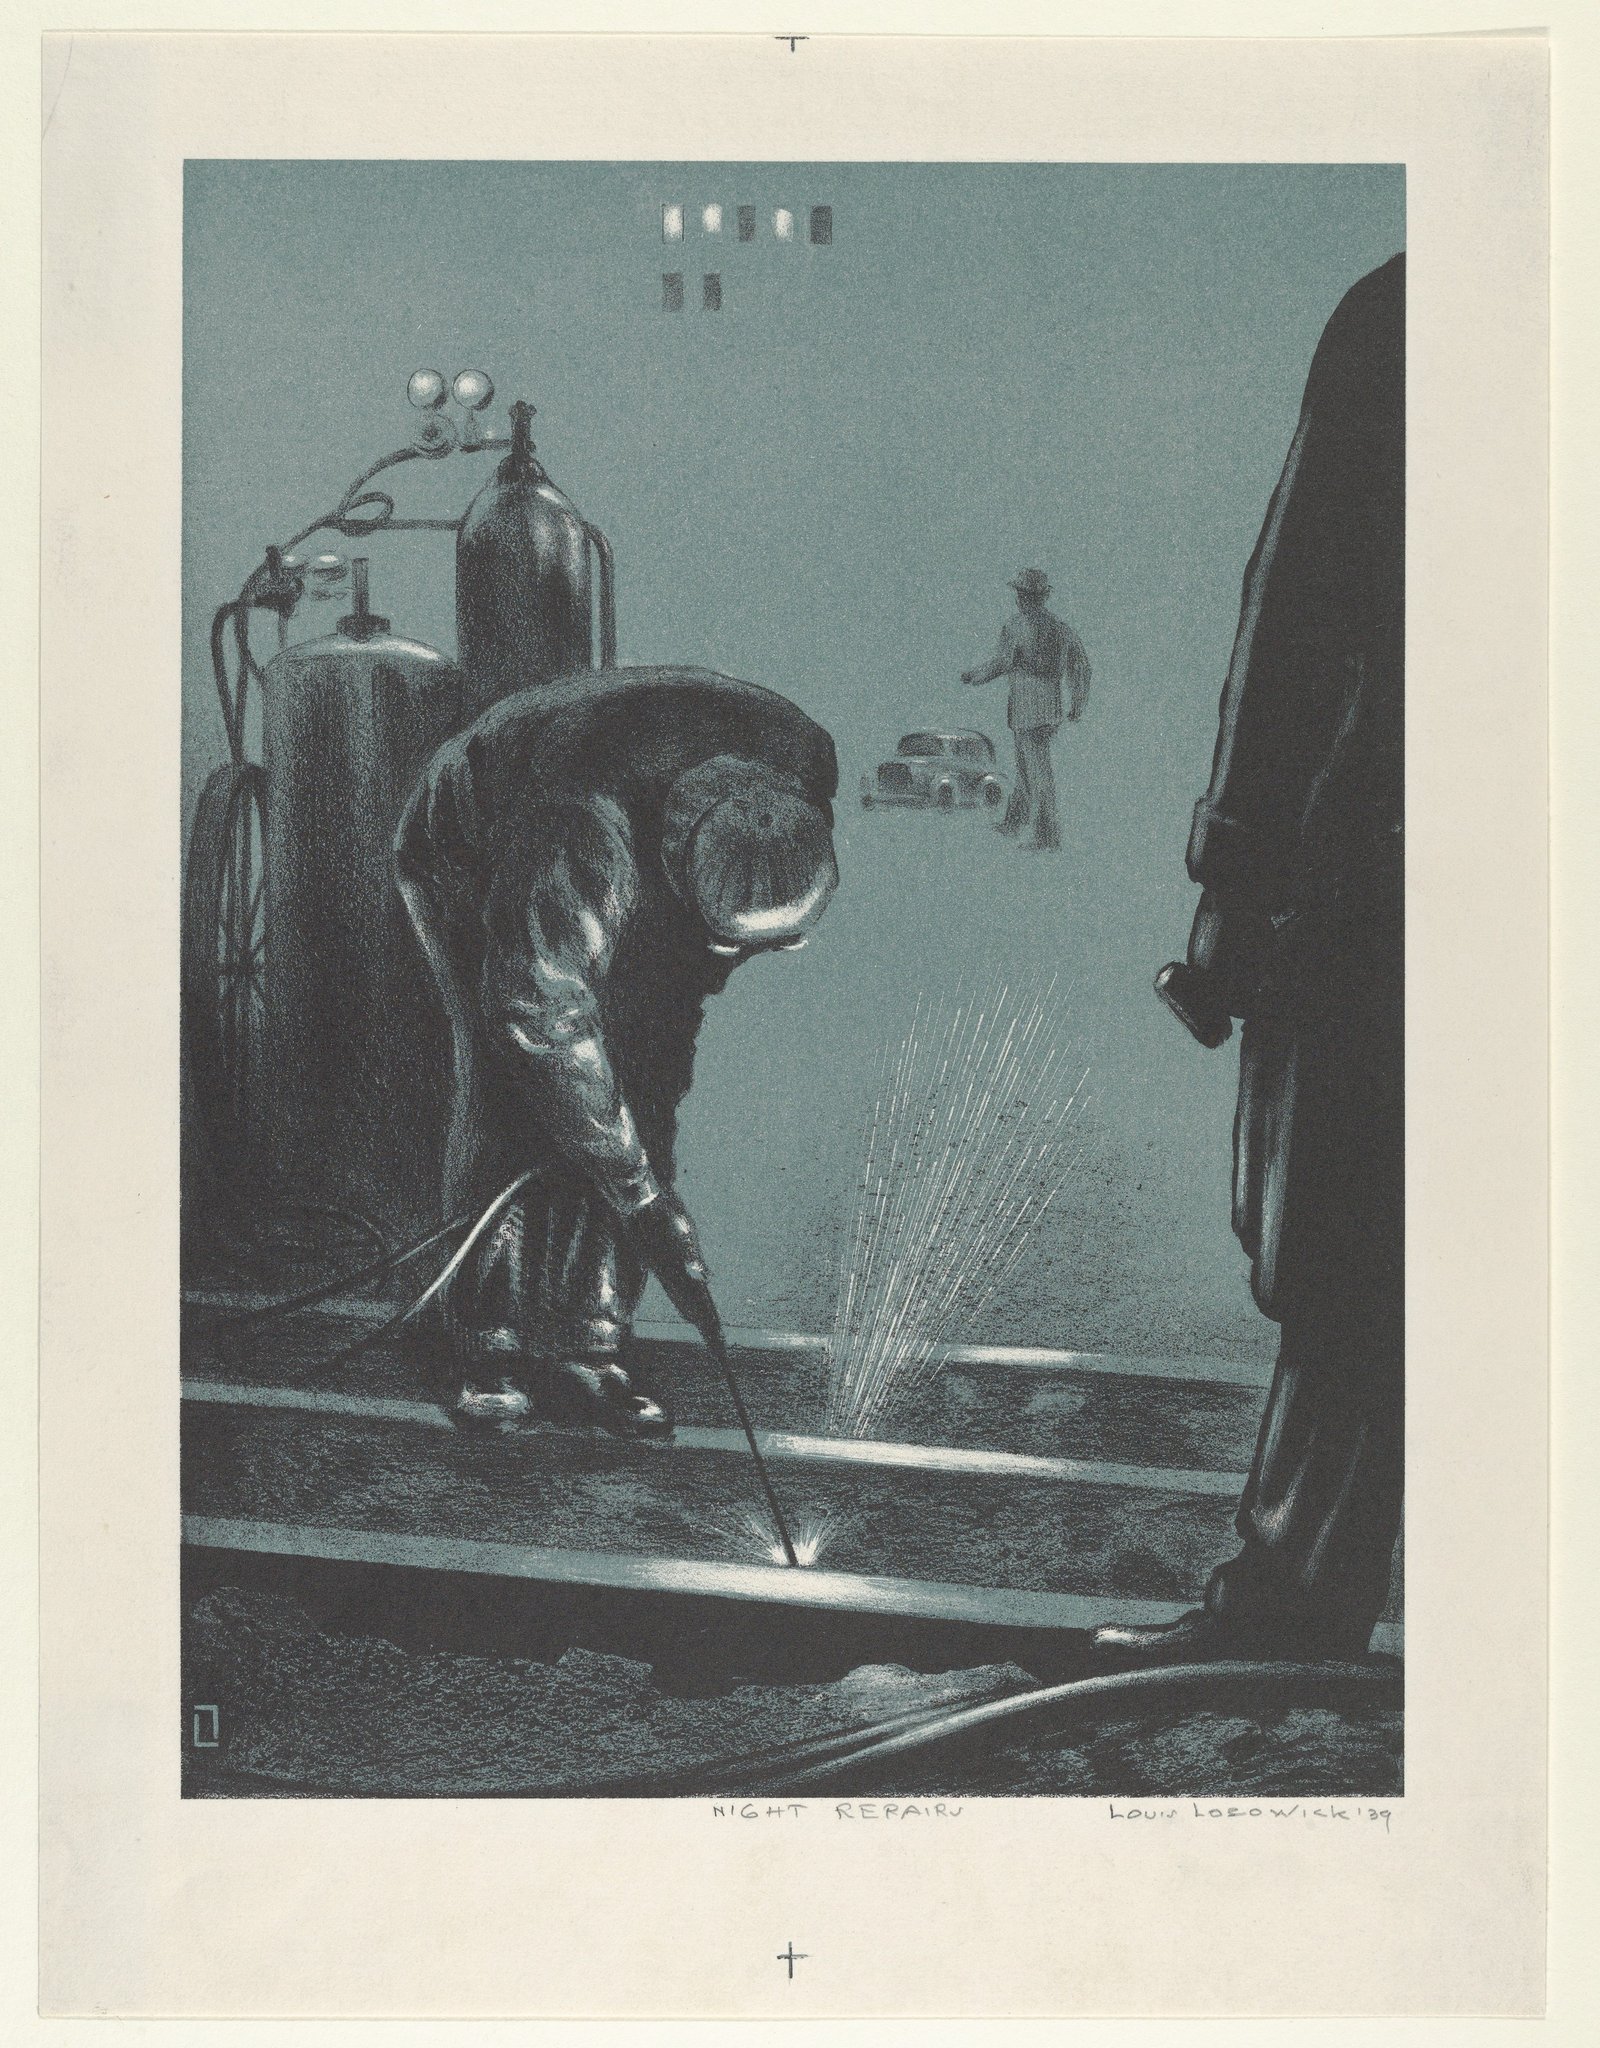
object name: print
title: Night Repairs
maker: louis lozowick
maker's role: artist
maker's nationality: american, born ukraine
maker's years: 1892-1973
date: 1939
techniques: lithograph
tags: men,night,working